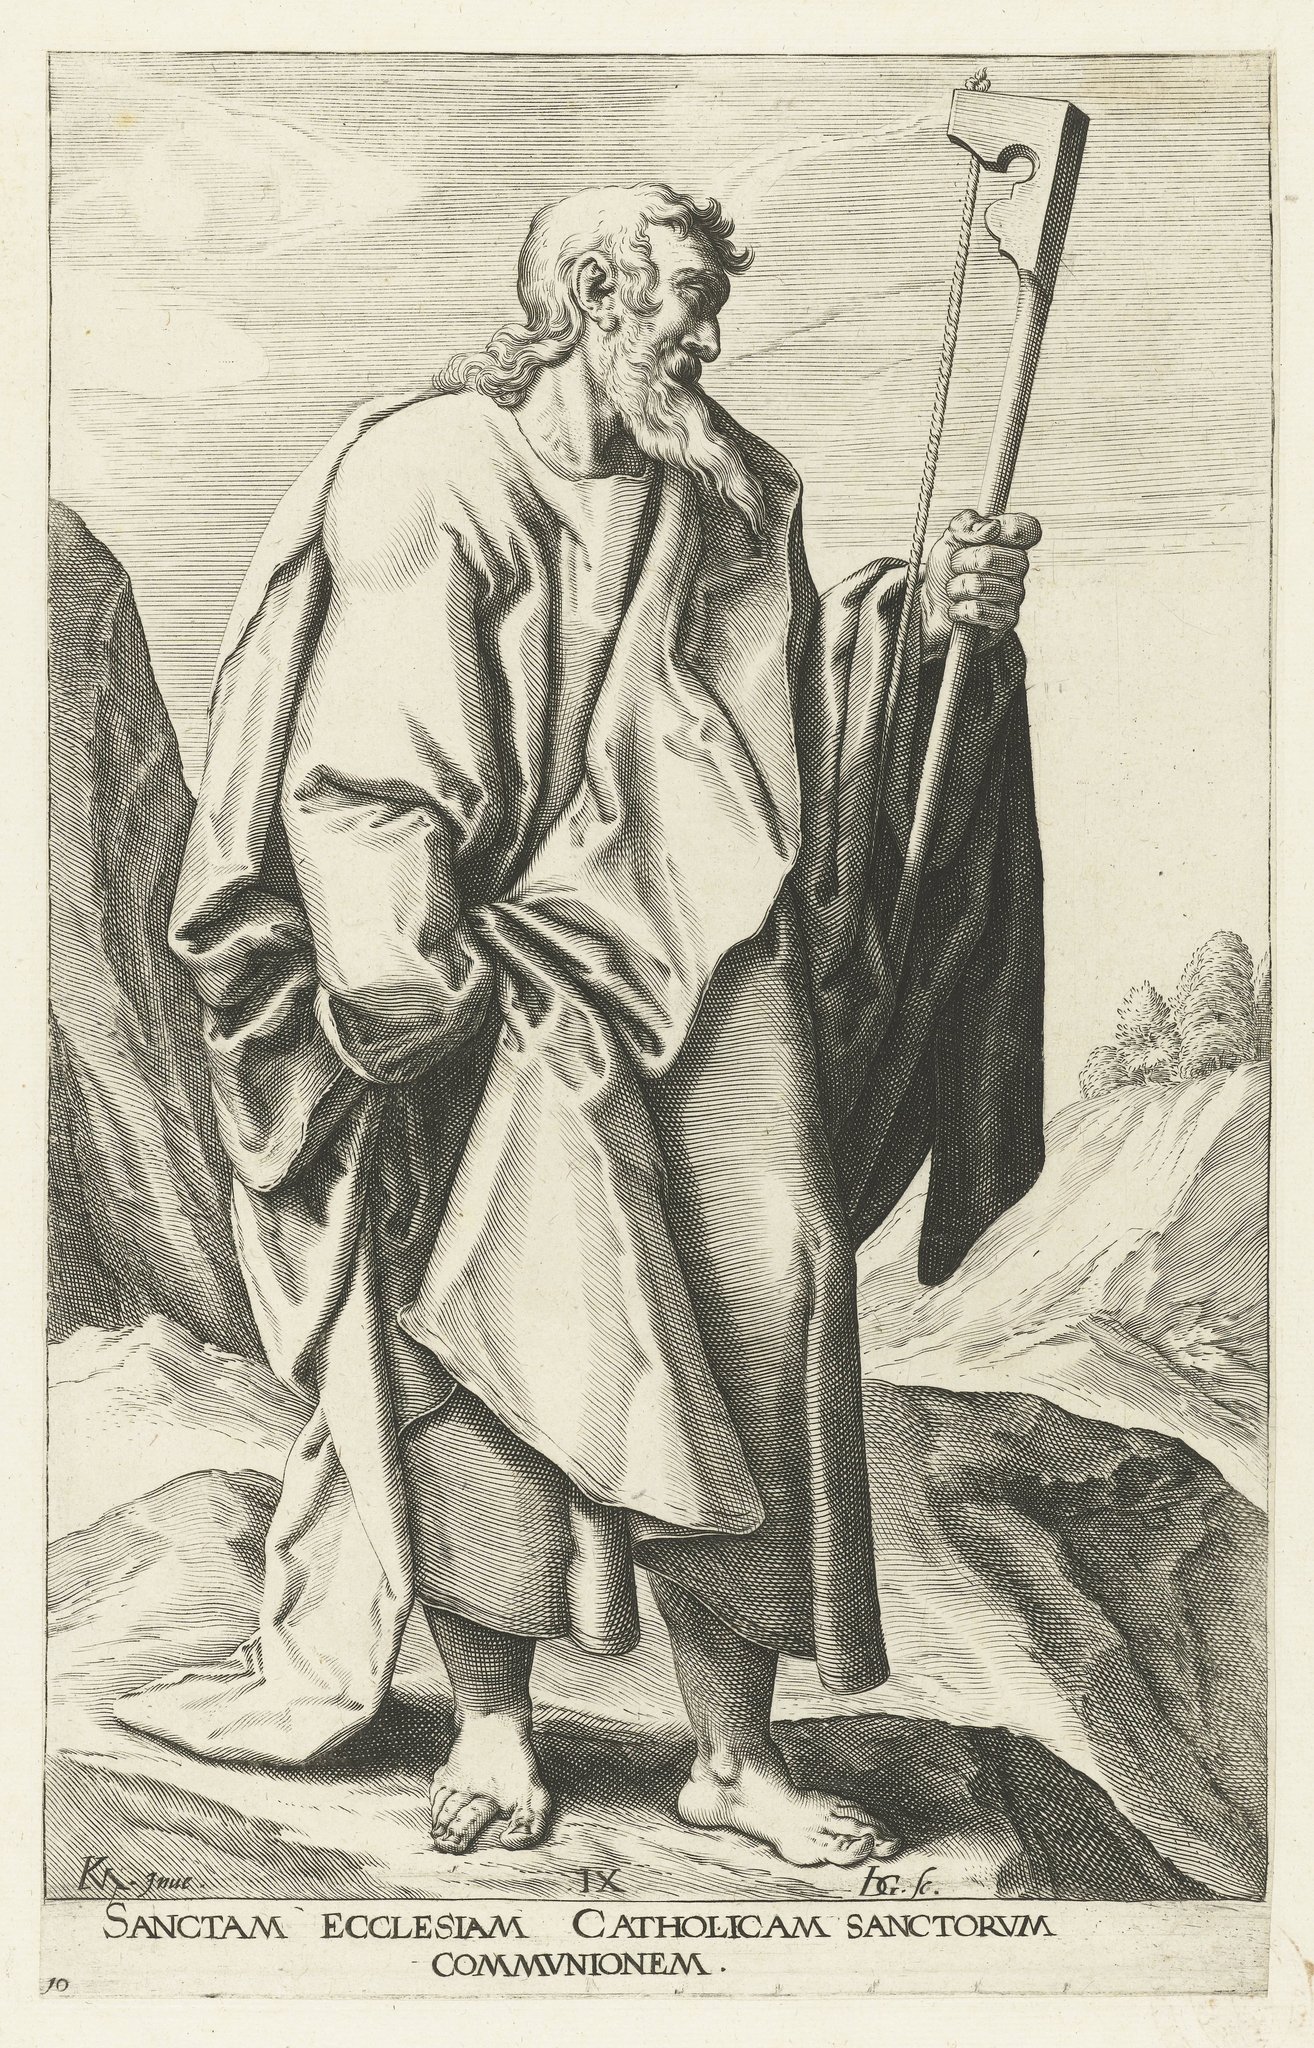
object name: print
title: Christus, de twaalf apostelen en de heilige Paulus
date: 1591-1592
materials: paper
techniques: engraving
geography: amsterdam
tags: the apostle james the less, first bishop of jerusalem; possible attributes: book, fuller's club, scroll, 'sanctam ecclesiam catholicam, sanctuorum communionem' ~ articles of faith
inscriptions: collector's mark: Lugt 240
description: De apostel Jakobus de Mindere, staand in een bergachtige omgeving, in de linkerhand een hoedenmakersboog (?). Onder de voorstelling twee regels Latijnse tekst. Deze prent is onderdeel van een serie van 14 prenten, elk bestaand uit een beeltenis ten voeten uit van een apostel, Christus of Paulus met typerende attributen en een onderschrift in Latijn.